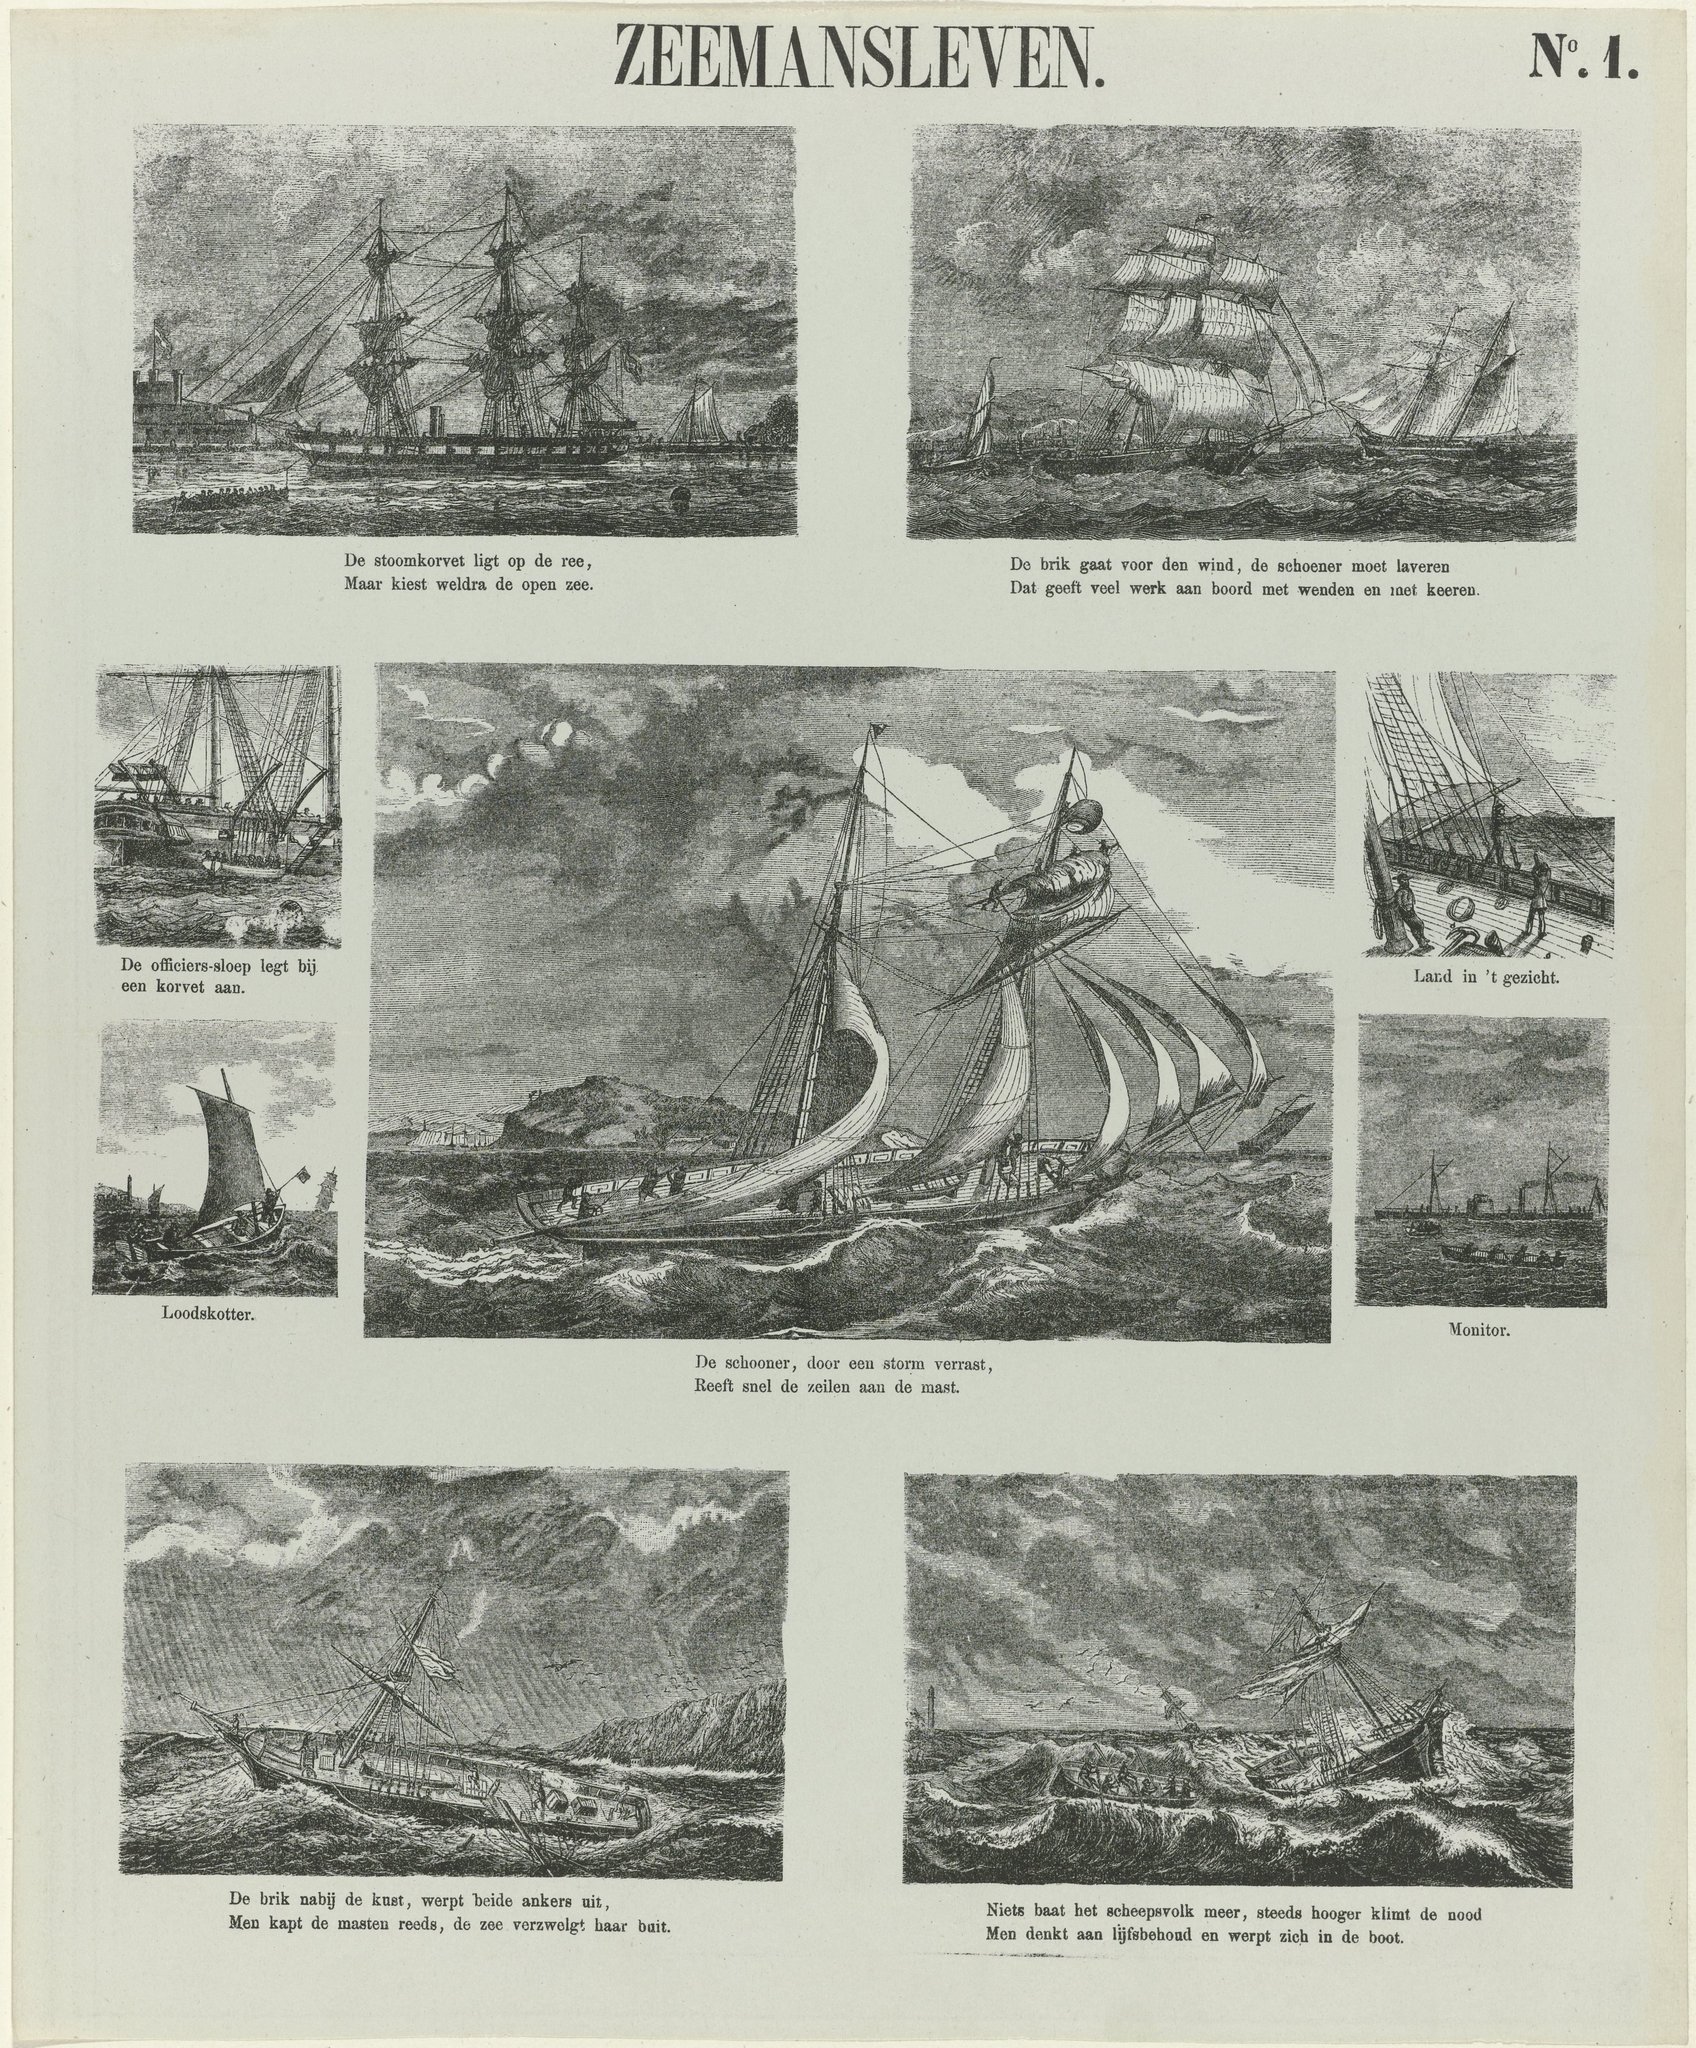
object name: print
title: Zeemansleven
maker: Anonymous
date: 1873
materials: paper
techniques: letterpress printing, lithograph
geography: amsterdam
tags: shipwreck, ships (in general)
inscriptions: collector's mark: Lugt 2760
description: Blad met 9 voorstellingen van verschillende scheepstypen en een scheepsramp. Onder elke afbeelding een onderschrift. Genummerd rechtsboven: No. 1.